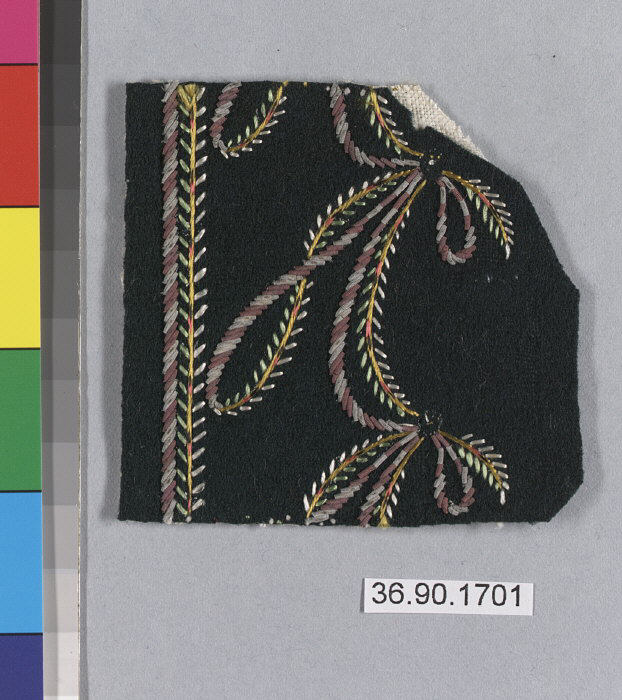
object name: sample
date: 1801-1833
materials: felt, metal thread, silk